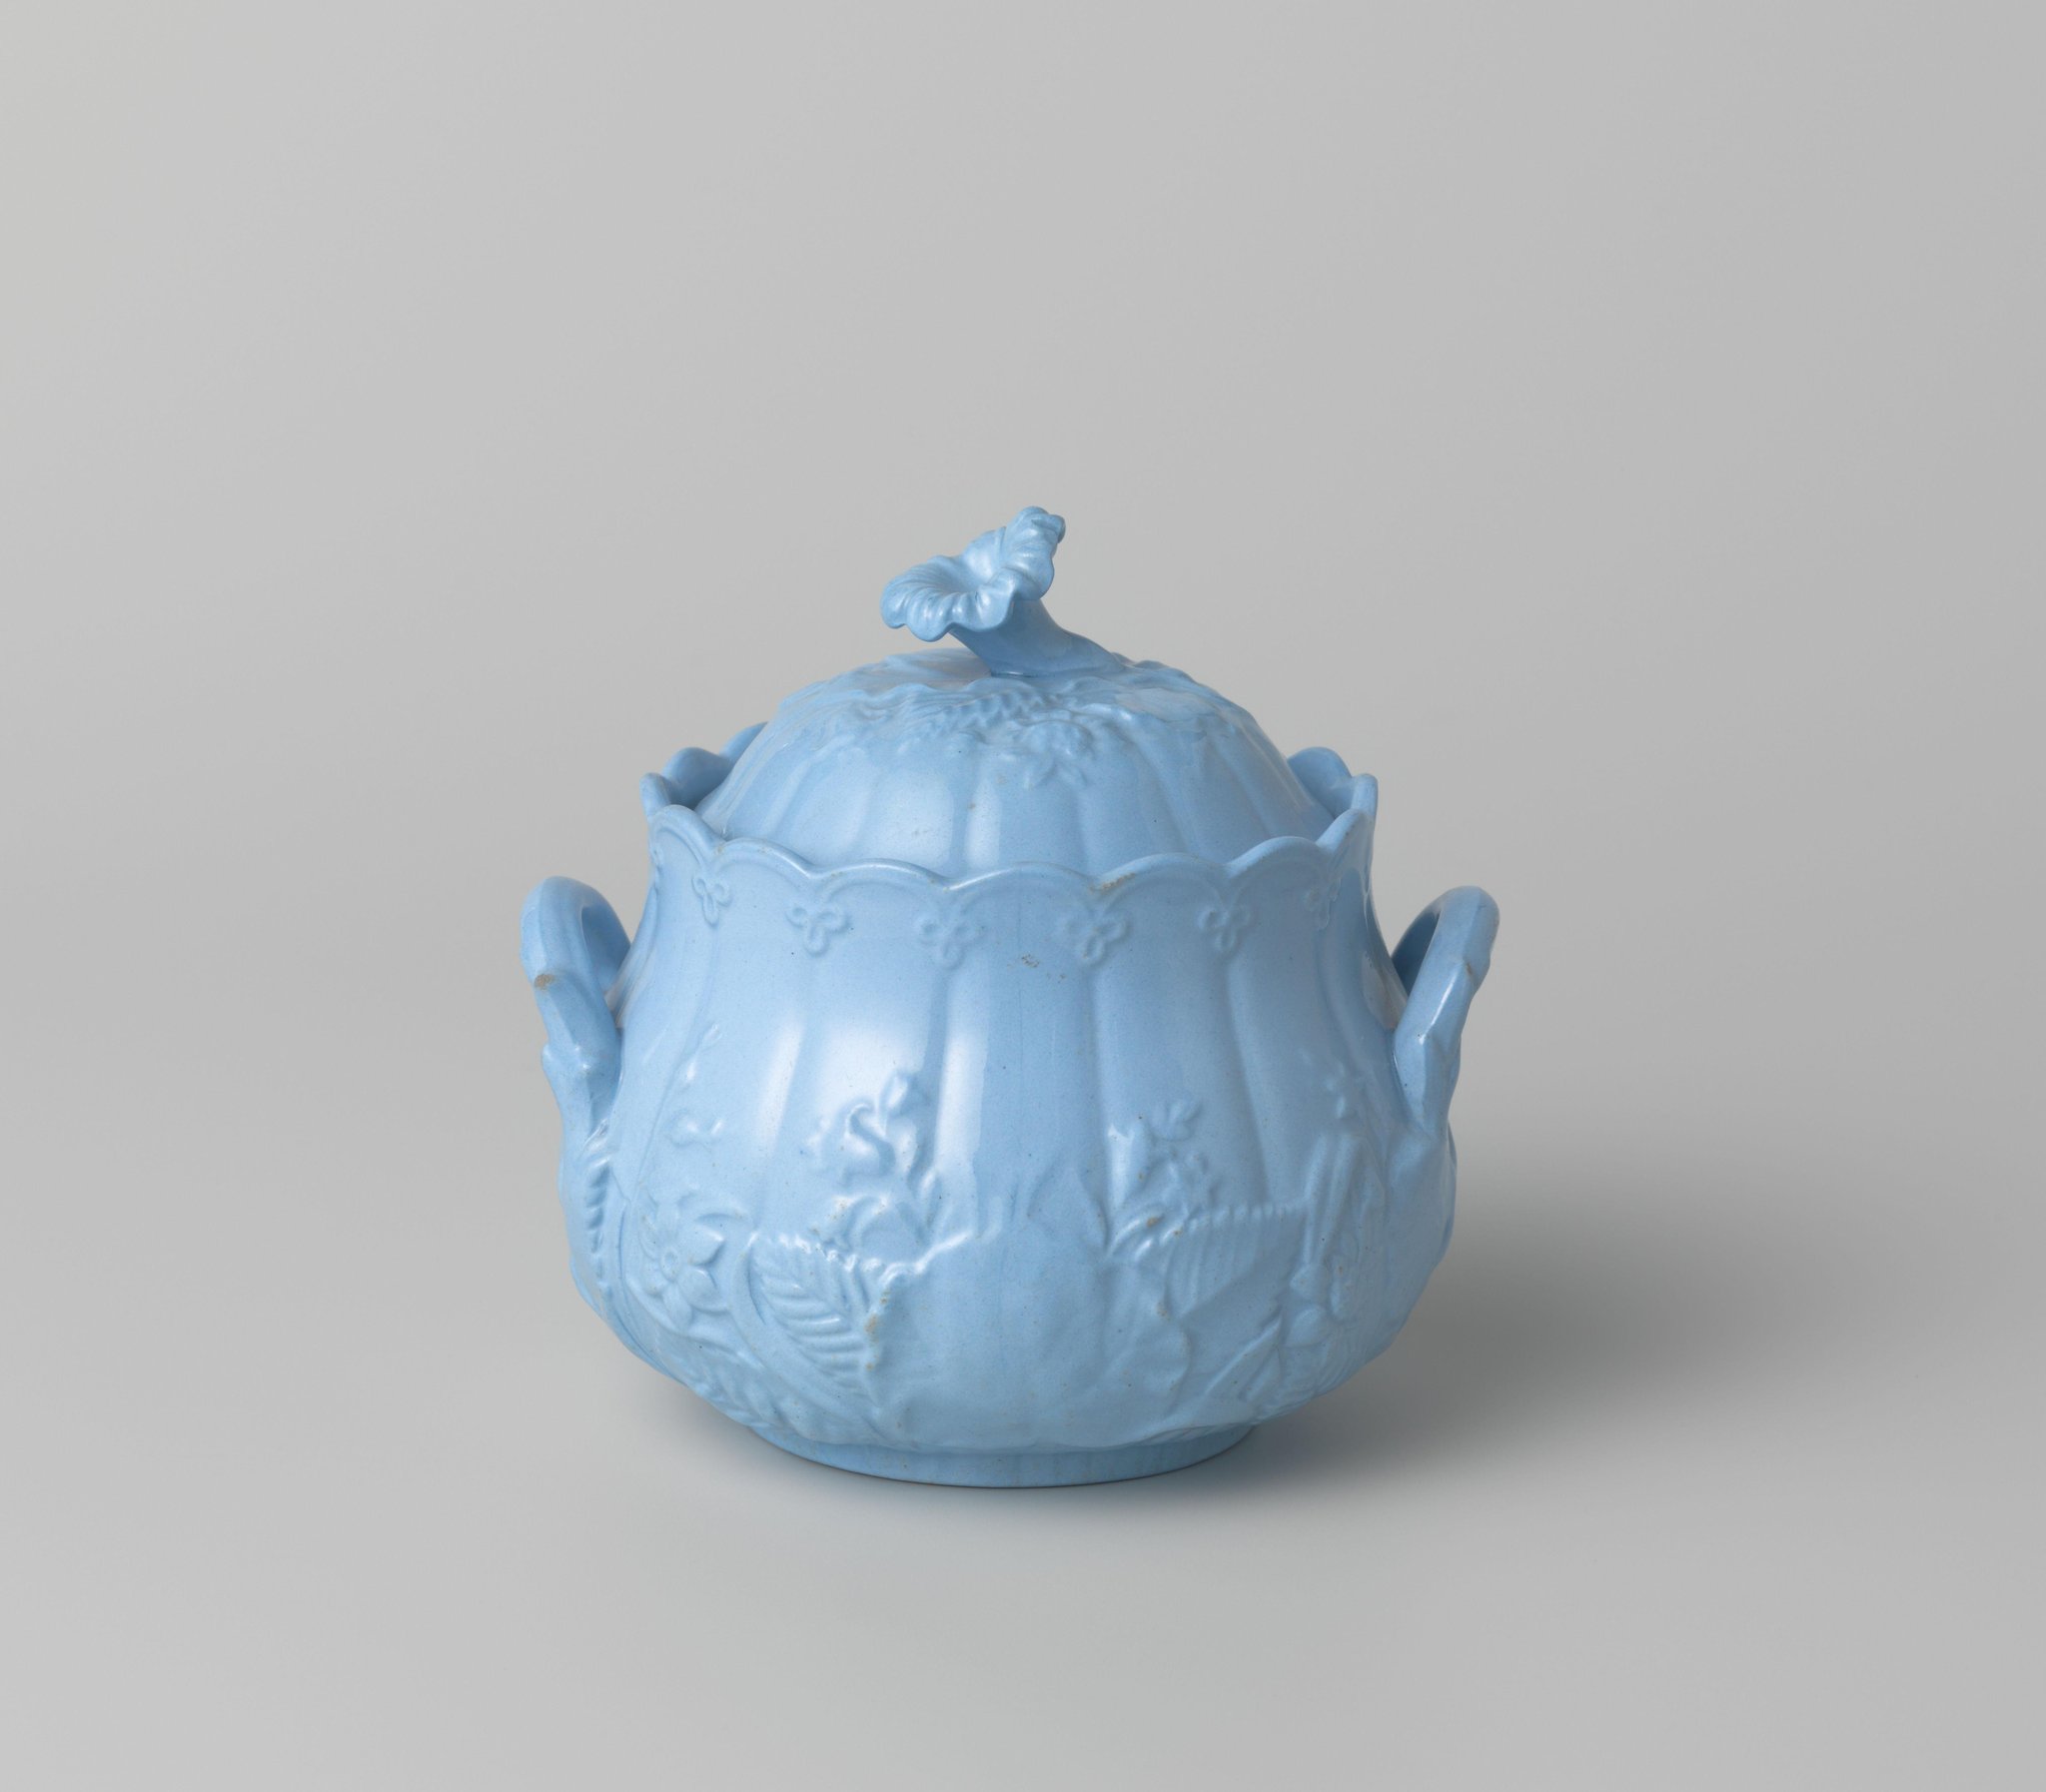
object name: sugar box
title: Deksel, blauw, met bloemen en bladeren in reliëf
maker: petrus regout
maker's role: plateelbakker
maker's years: 1801-1879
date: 1860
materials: stoneware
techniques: engels steengoed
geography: maastricht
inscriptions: mark: ‘P. REGOUT // MAASTRICHT // 21’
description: Deksel van aardewerk, blauwsteen. Het deksel met een reliëf van bladeren en bloemen, de dekselknop in de vorm van een kelkbloem.